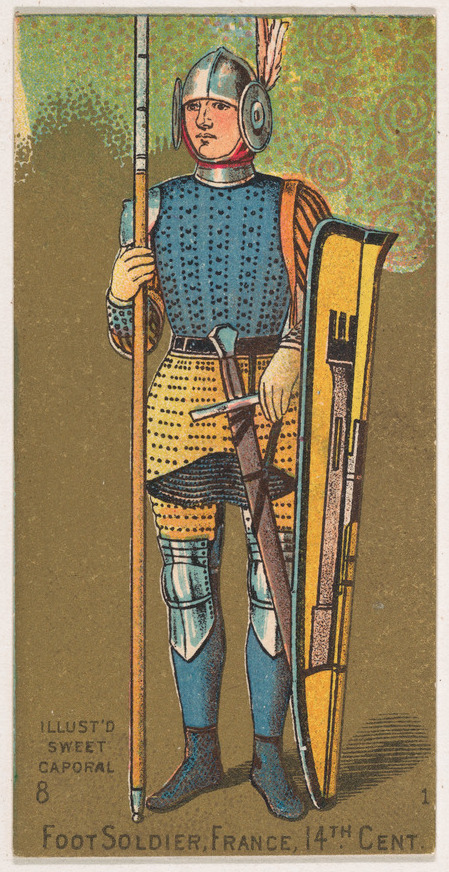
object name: print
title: Foot Soldier, France, 14th Century, from the Military Series (N224) issued by Kinney Tobacco Company to promote Sweet Caporal Cigarettes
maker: kinney brothers tobacco company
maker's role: publisher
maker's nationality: american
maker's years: 1869-2011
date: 1888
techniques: color lithograph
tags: military,men